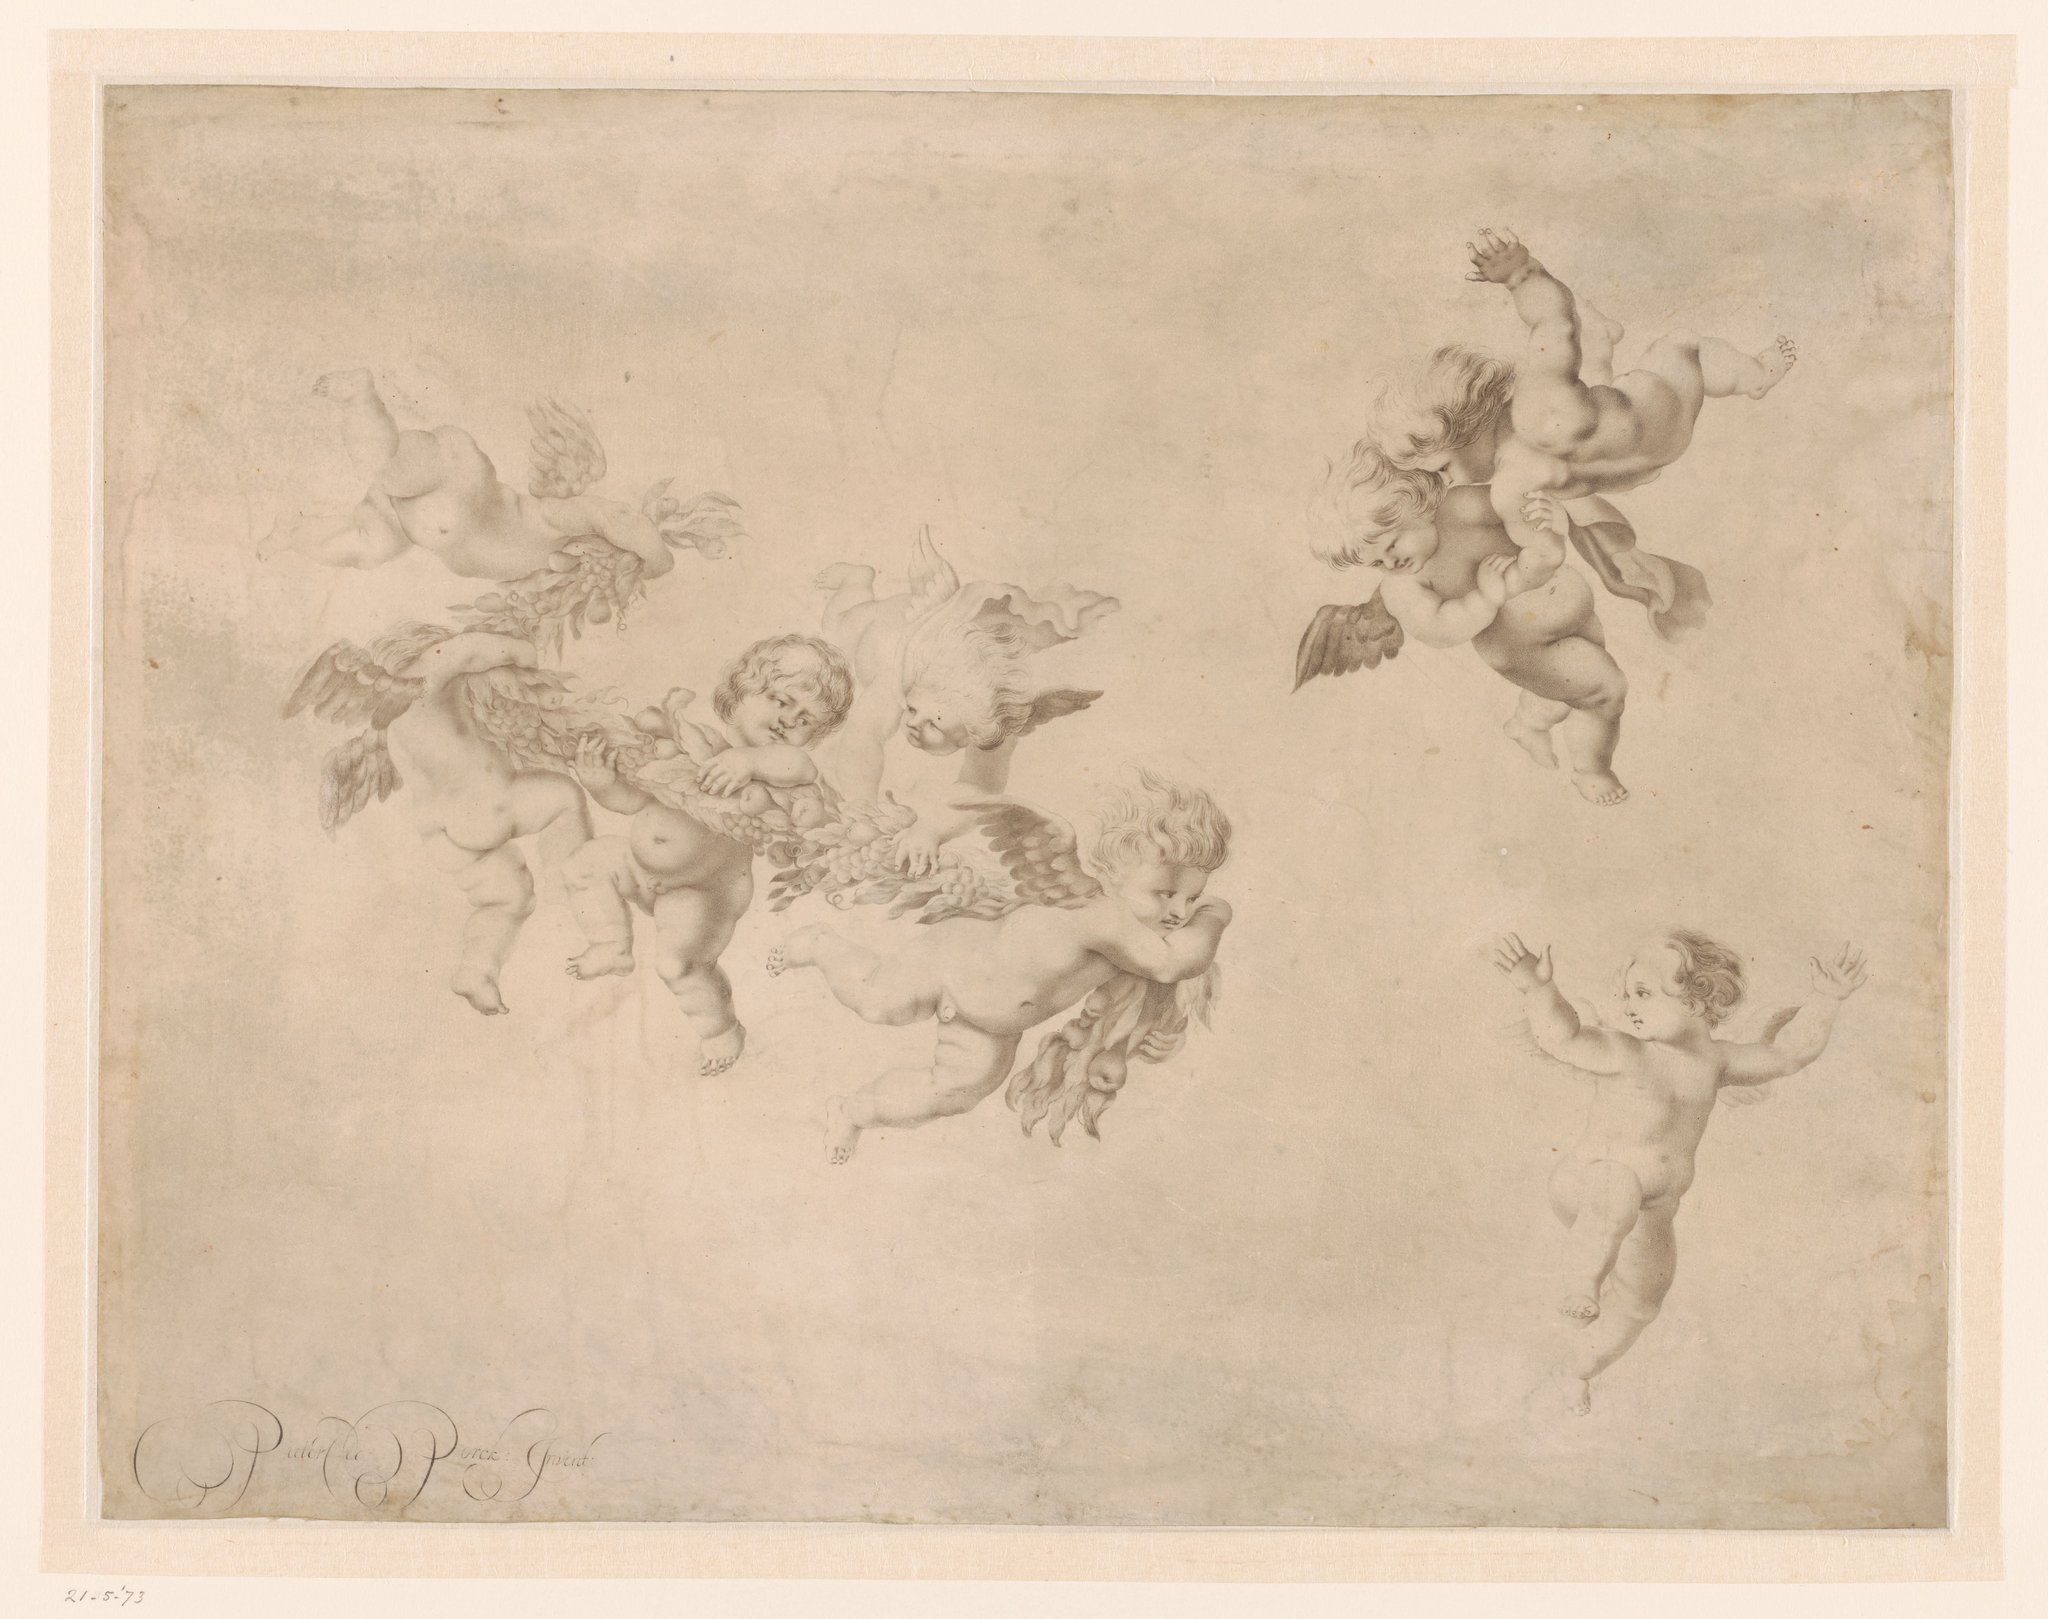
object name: drawing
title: Putti met een guirlande van vruchten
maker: pieter de porck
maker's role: draughtsman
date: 1640-1660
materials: ink, parchment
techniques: pen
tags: fruits and vegetables ~ ornament, ornament ~ festoon, garland, cupids: 'amores', 'amoretti', 'putti'